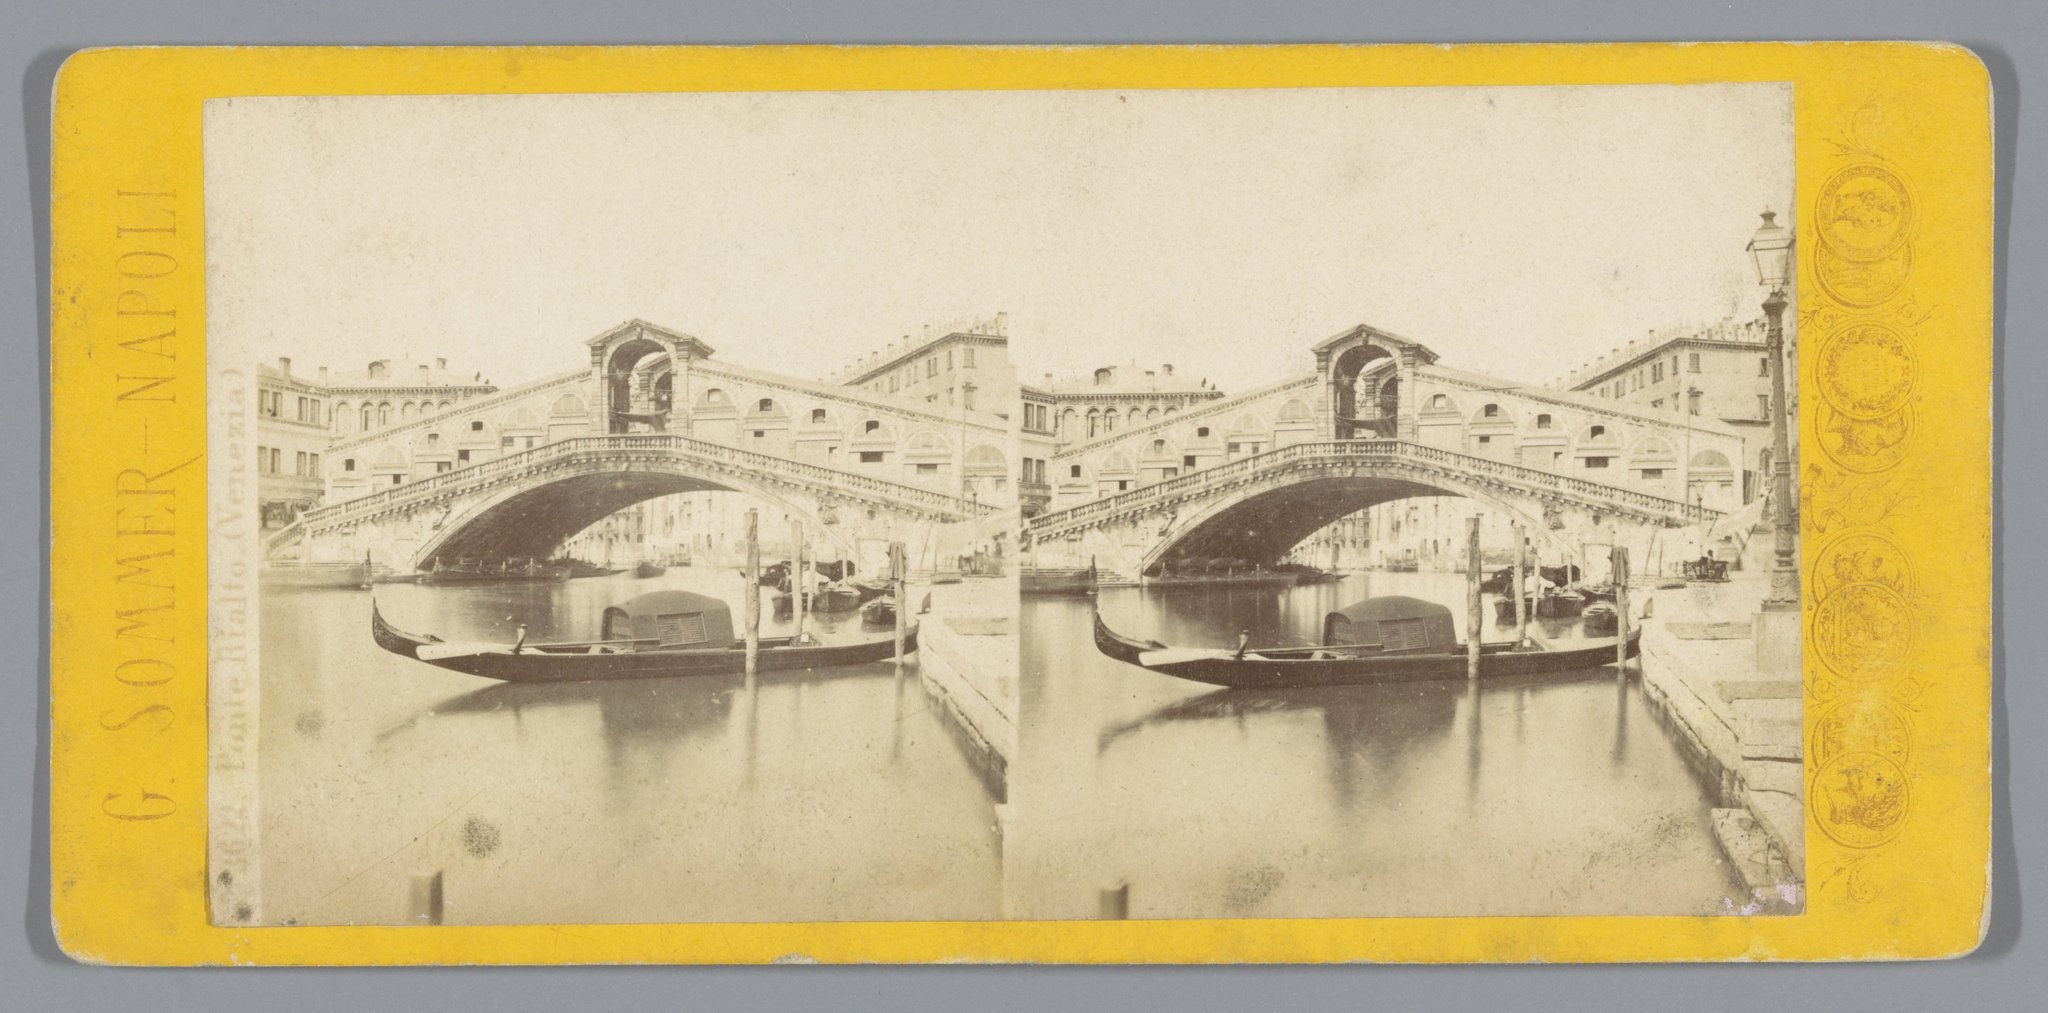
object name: stereograph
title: Ponte Rialto.(Venezia)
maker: giorgio sommer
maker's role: fotograaf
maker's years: 1834-1914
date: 1860-1880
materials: cardboard, photographic support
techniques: albumen print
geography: venice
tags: bridge in city across river, canal, etc.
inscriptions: number: ‘3622’, inscription: ‘Venetie : Ponte Rialto’